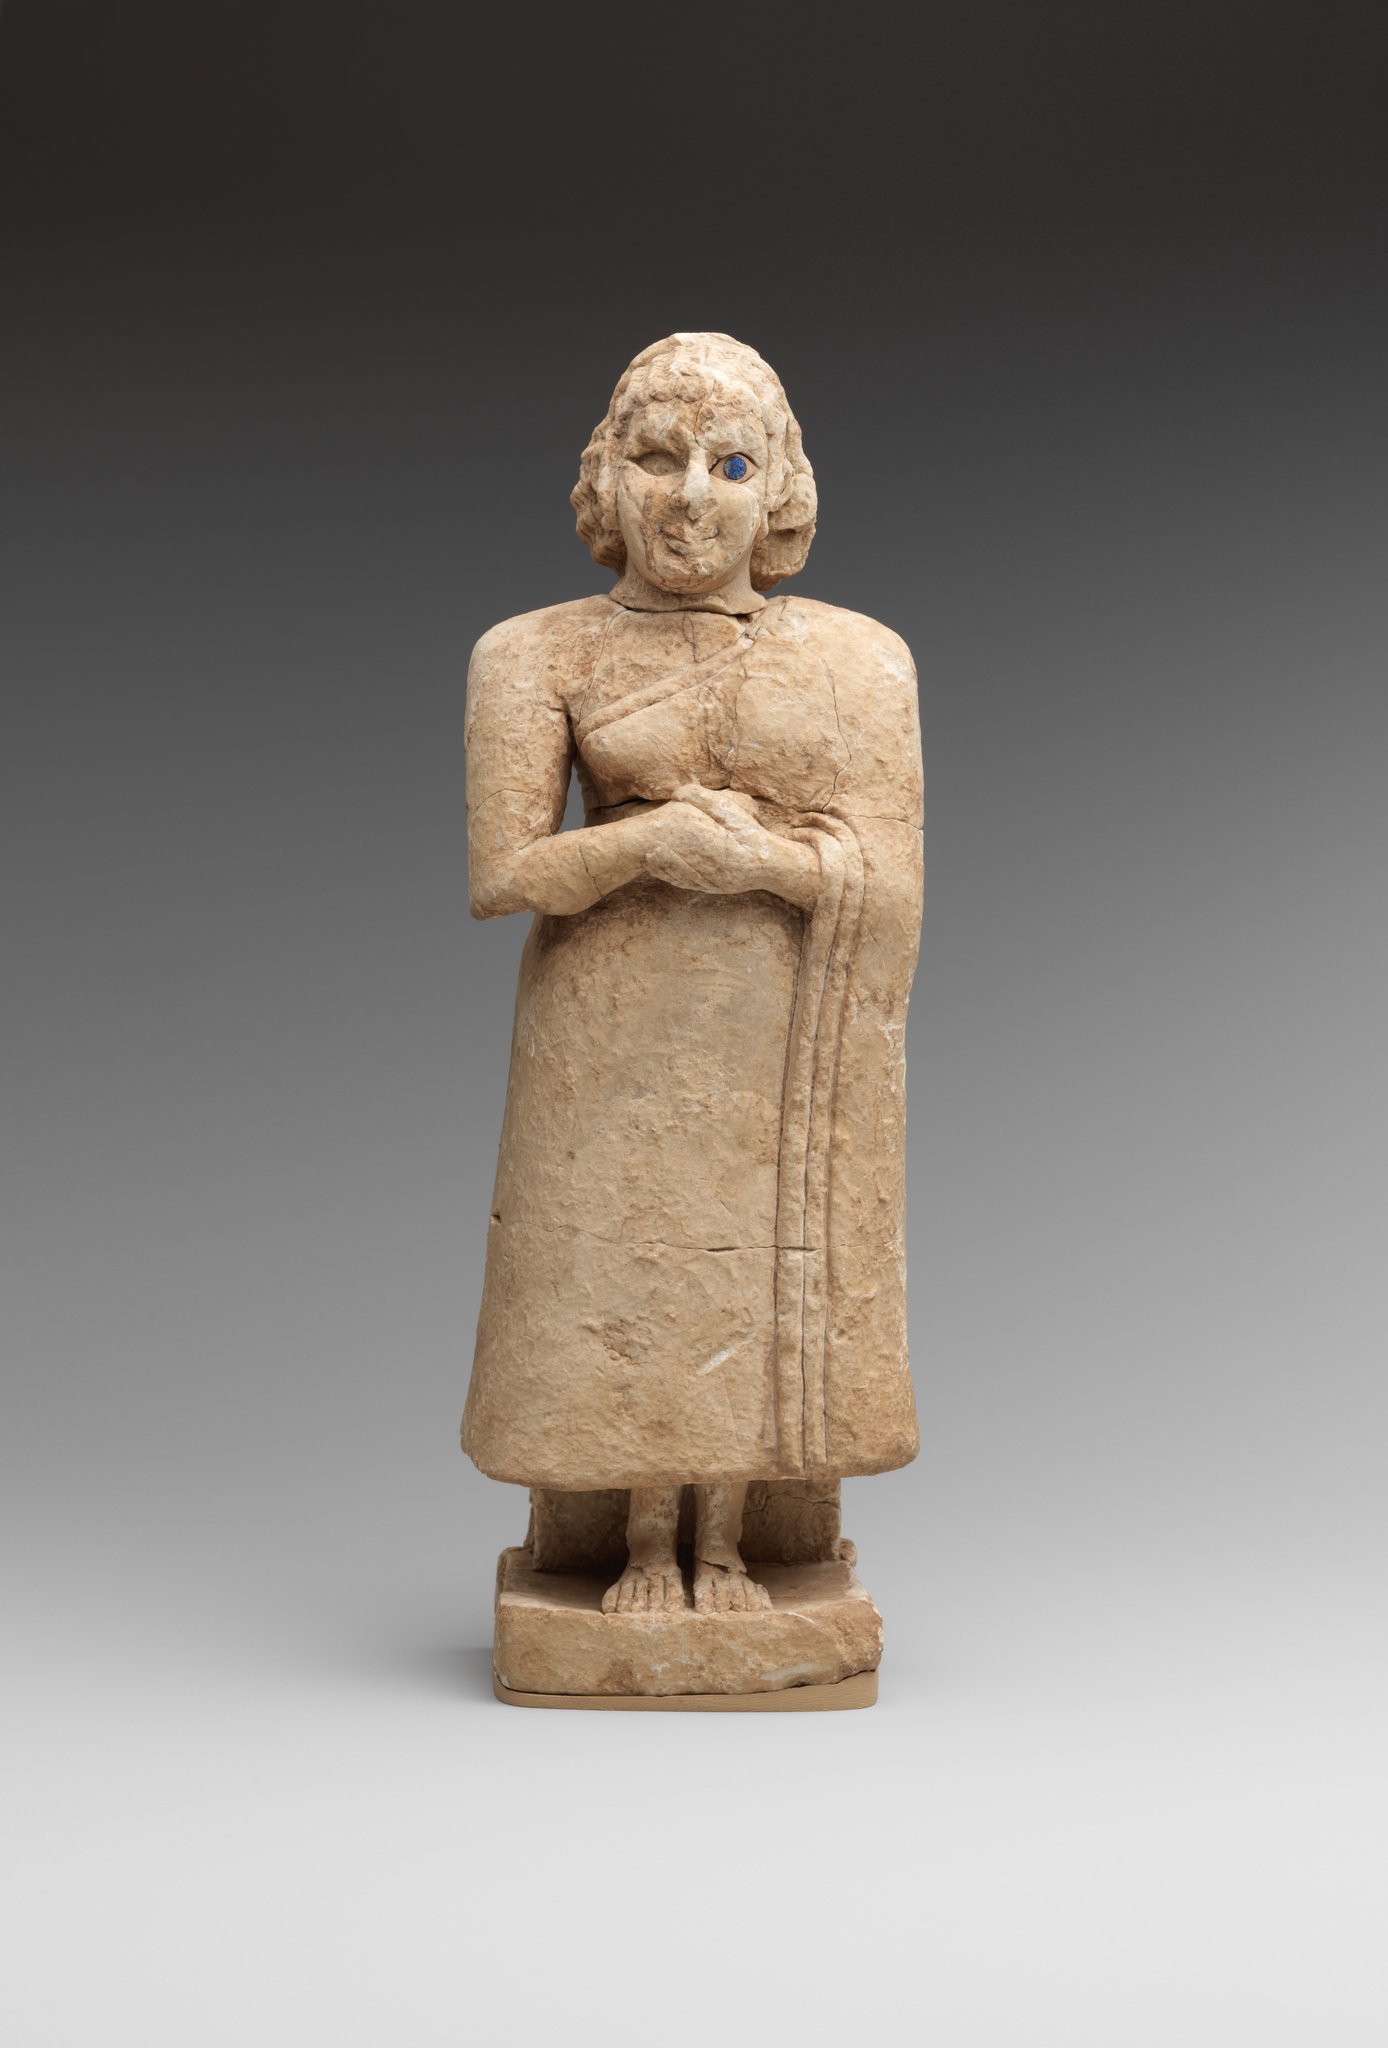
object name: sculpture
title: Standing female worshiper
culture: sumerian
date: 2600-2500 BCE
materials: lapis lazuli, limestone, shell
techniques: inlay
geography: mesopotamia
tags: women